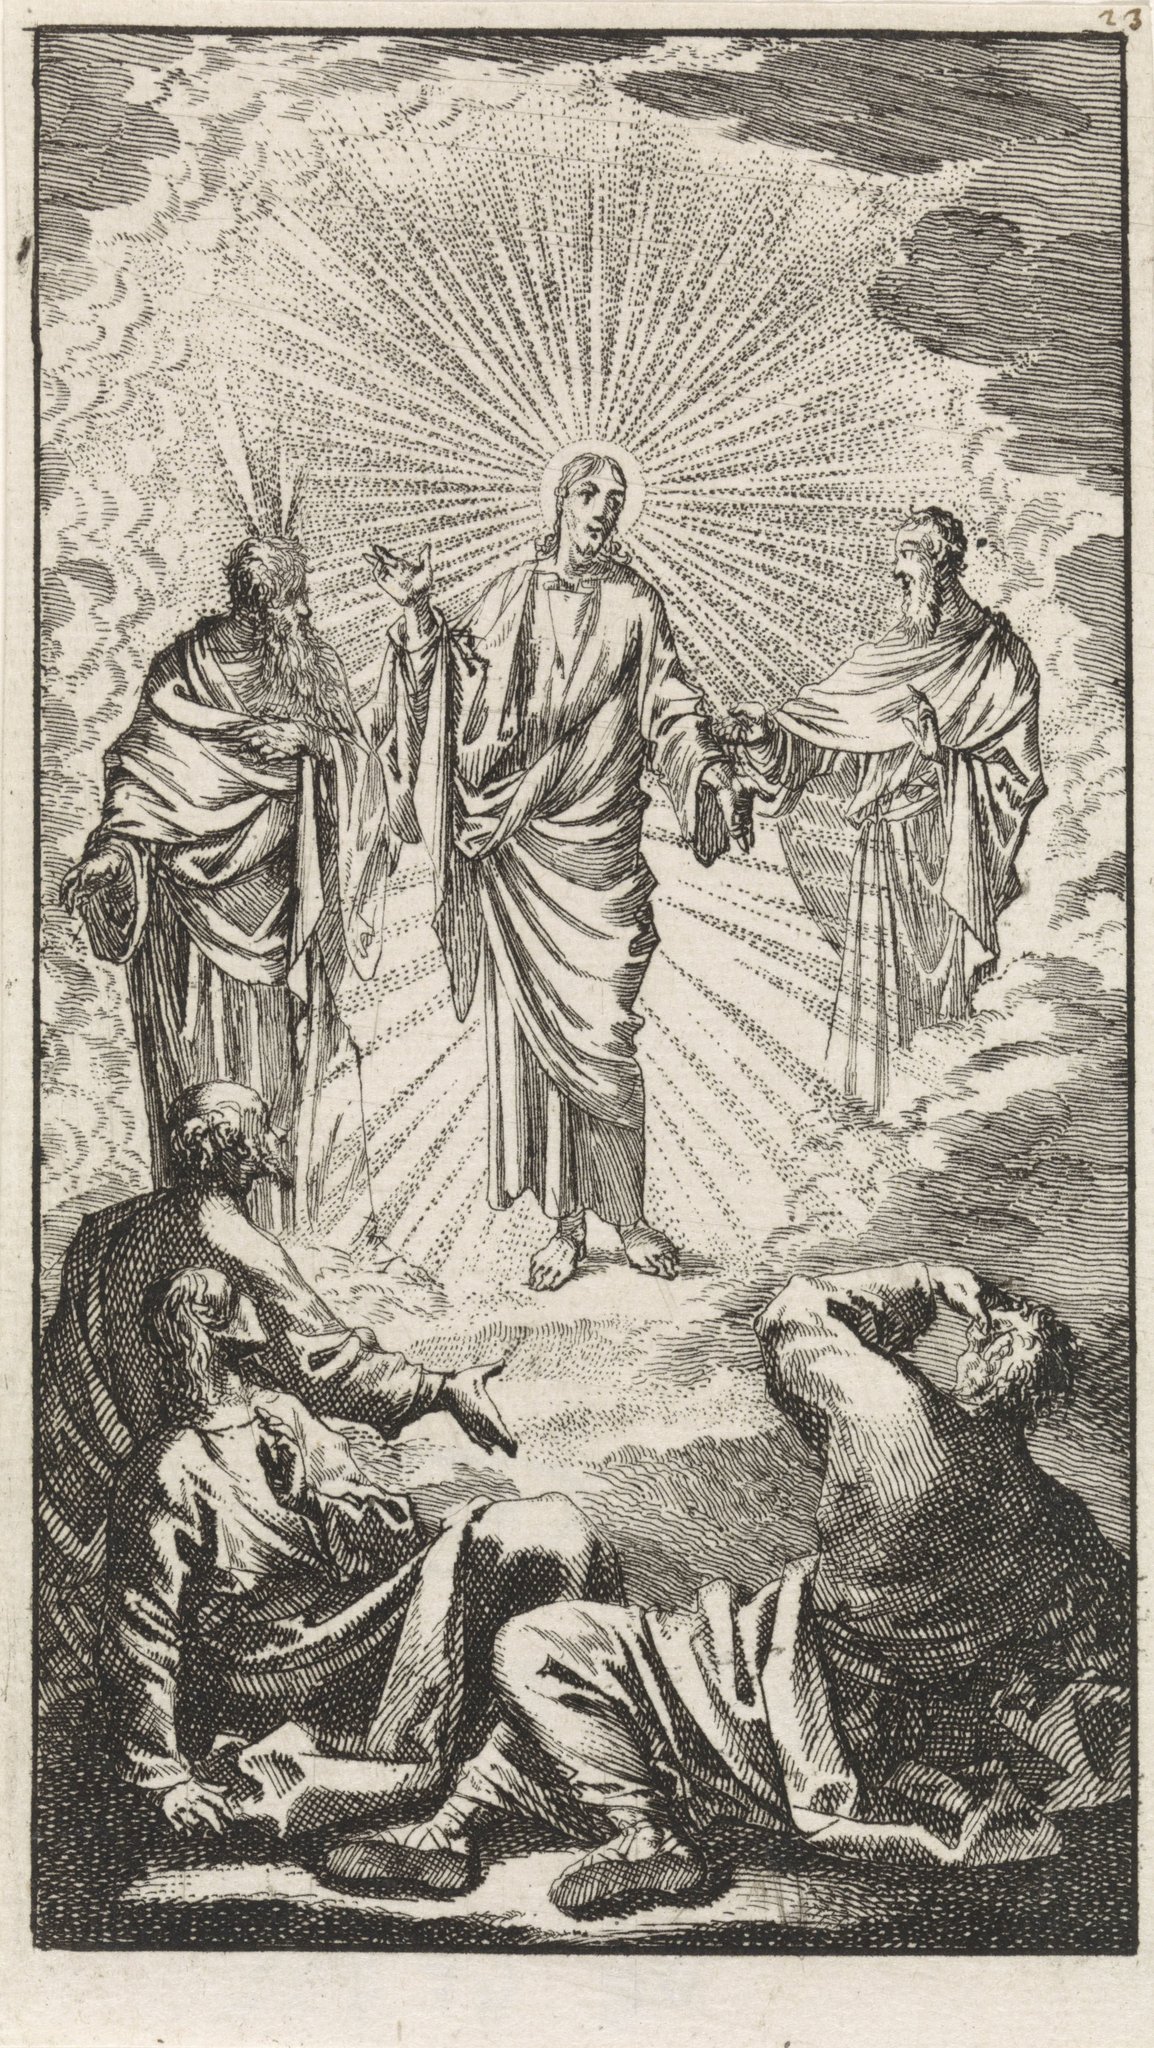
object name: print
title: Transfiguratie van Christus op de berg Tabor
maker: jan luyken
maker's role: draughtsman, print maker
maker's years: 1649-1712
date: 1712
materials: paper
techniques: etching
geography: amsterdam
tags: the transfiguration: moses and elijah appear on either side of christ on mount tabor (matthew 17:1-13; mark 9:2-13; luke 9:28-36)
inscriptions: collector's mark: Lugt 2228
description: Proefdruk van illustratie voor: Luyken, Jan. Bybel printen. Amsterdam: Pieter Arentsz. II (wed.) en Cornelis van der Sys, 1712, p. 23.